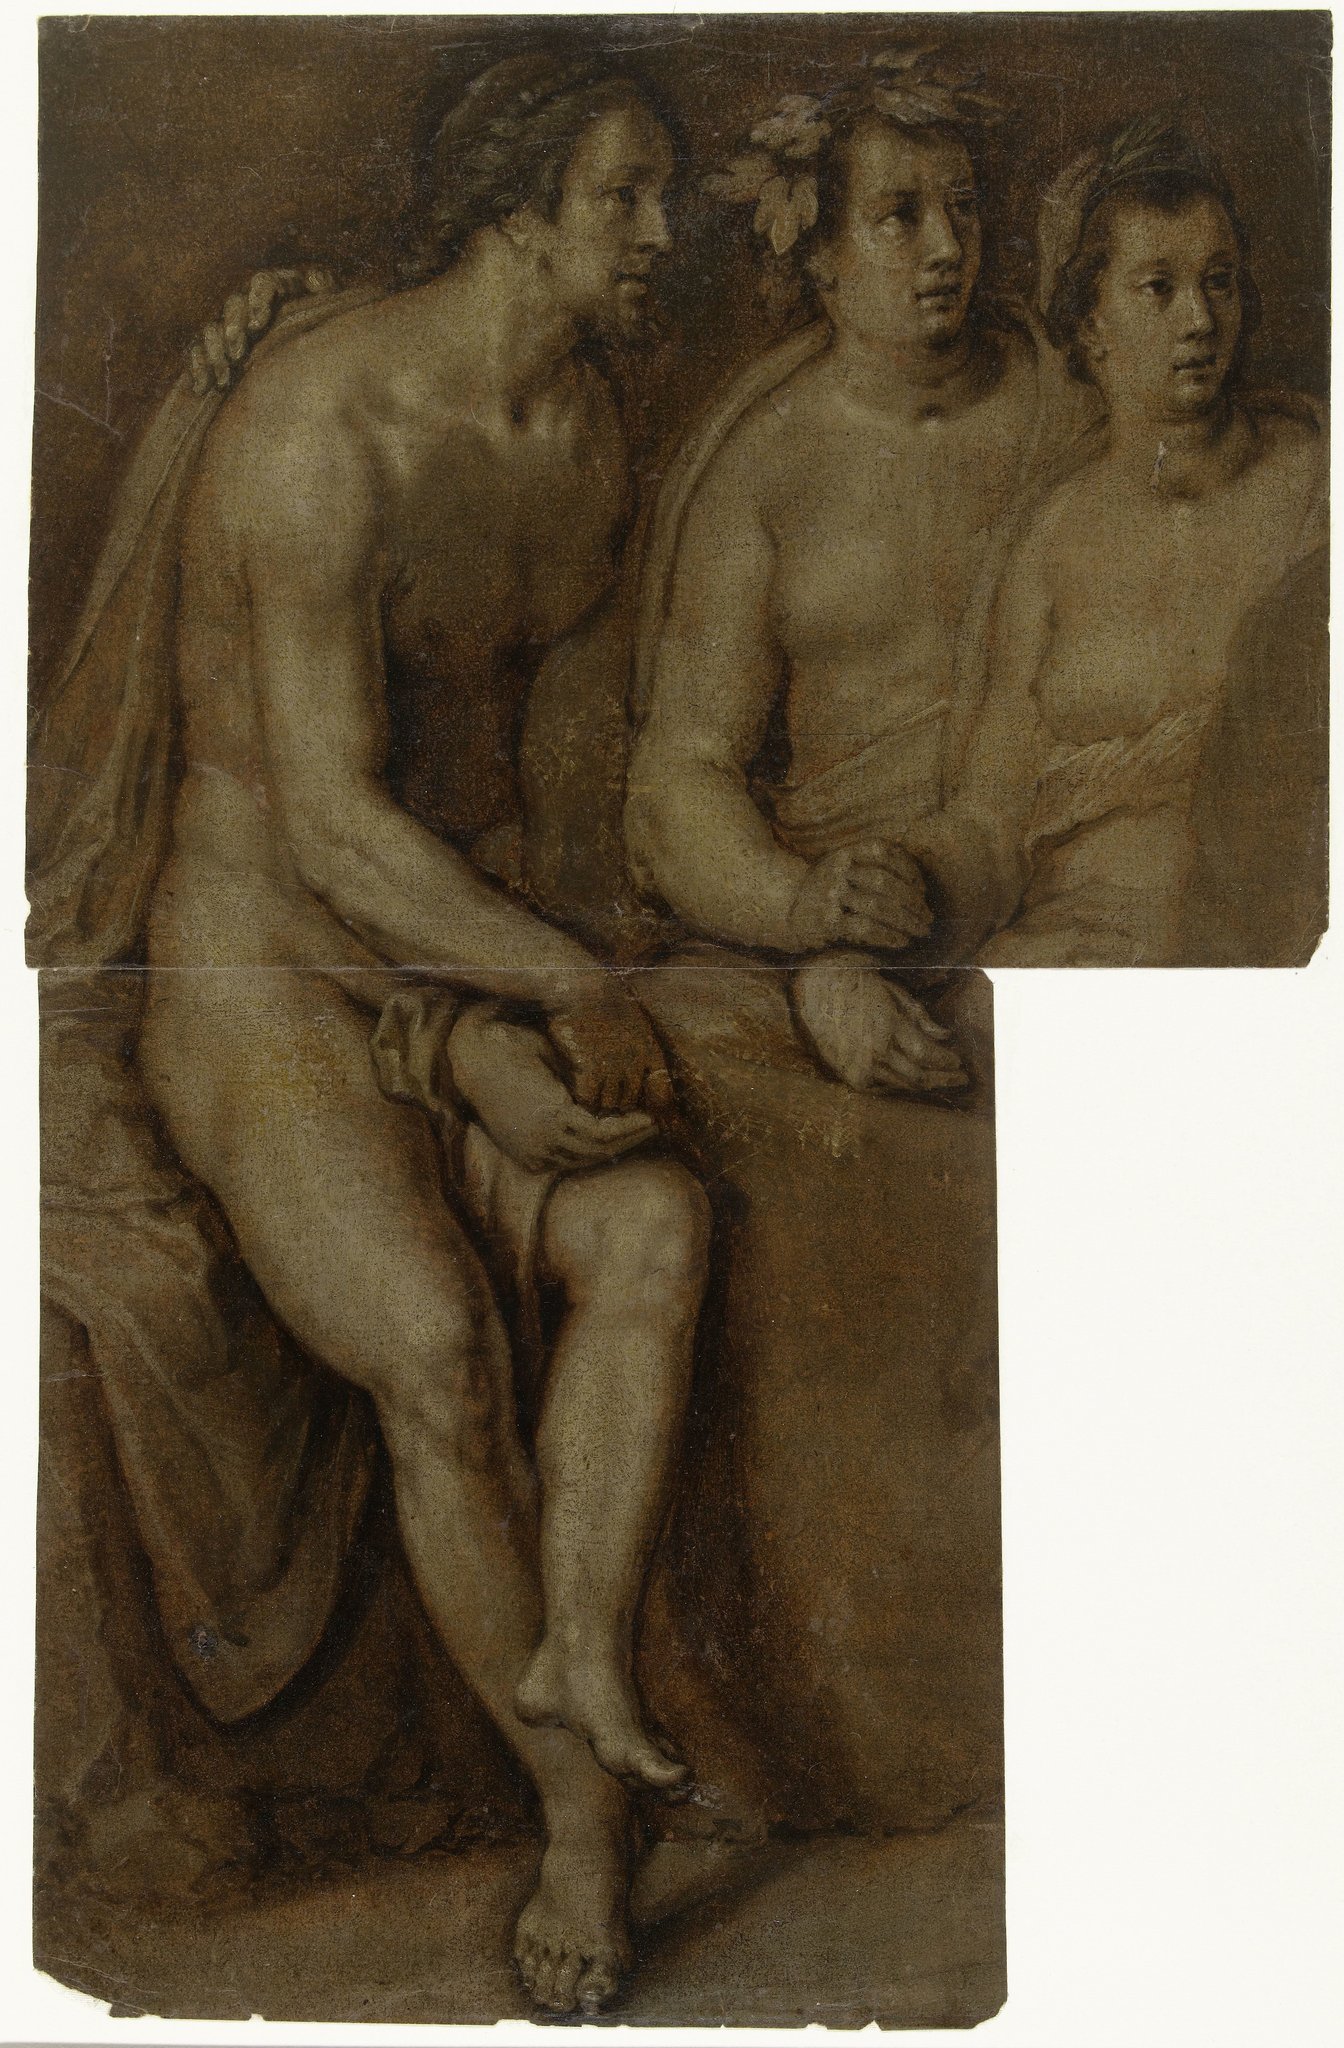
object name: drawing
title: Studies van een zittende naakte man en twee vrouwen, ten halven lijve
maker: cornelis cornelisz. van haarlem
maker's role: draughtsman, painter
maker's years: 1562-1638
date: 1620-1625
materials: oil, paper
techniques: grisaille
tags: sitting figure, sitting figure - aa - female human figure